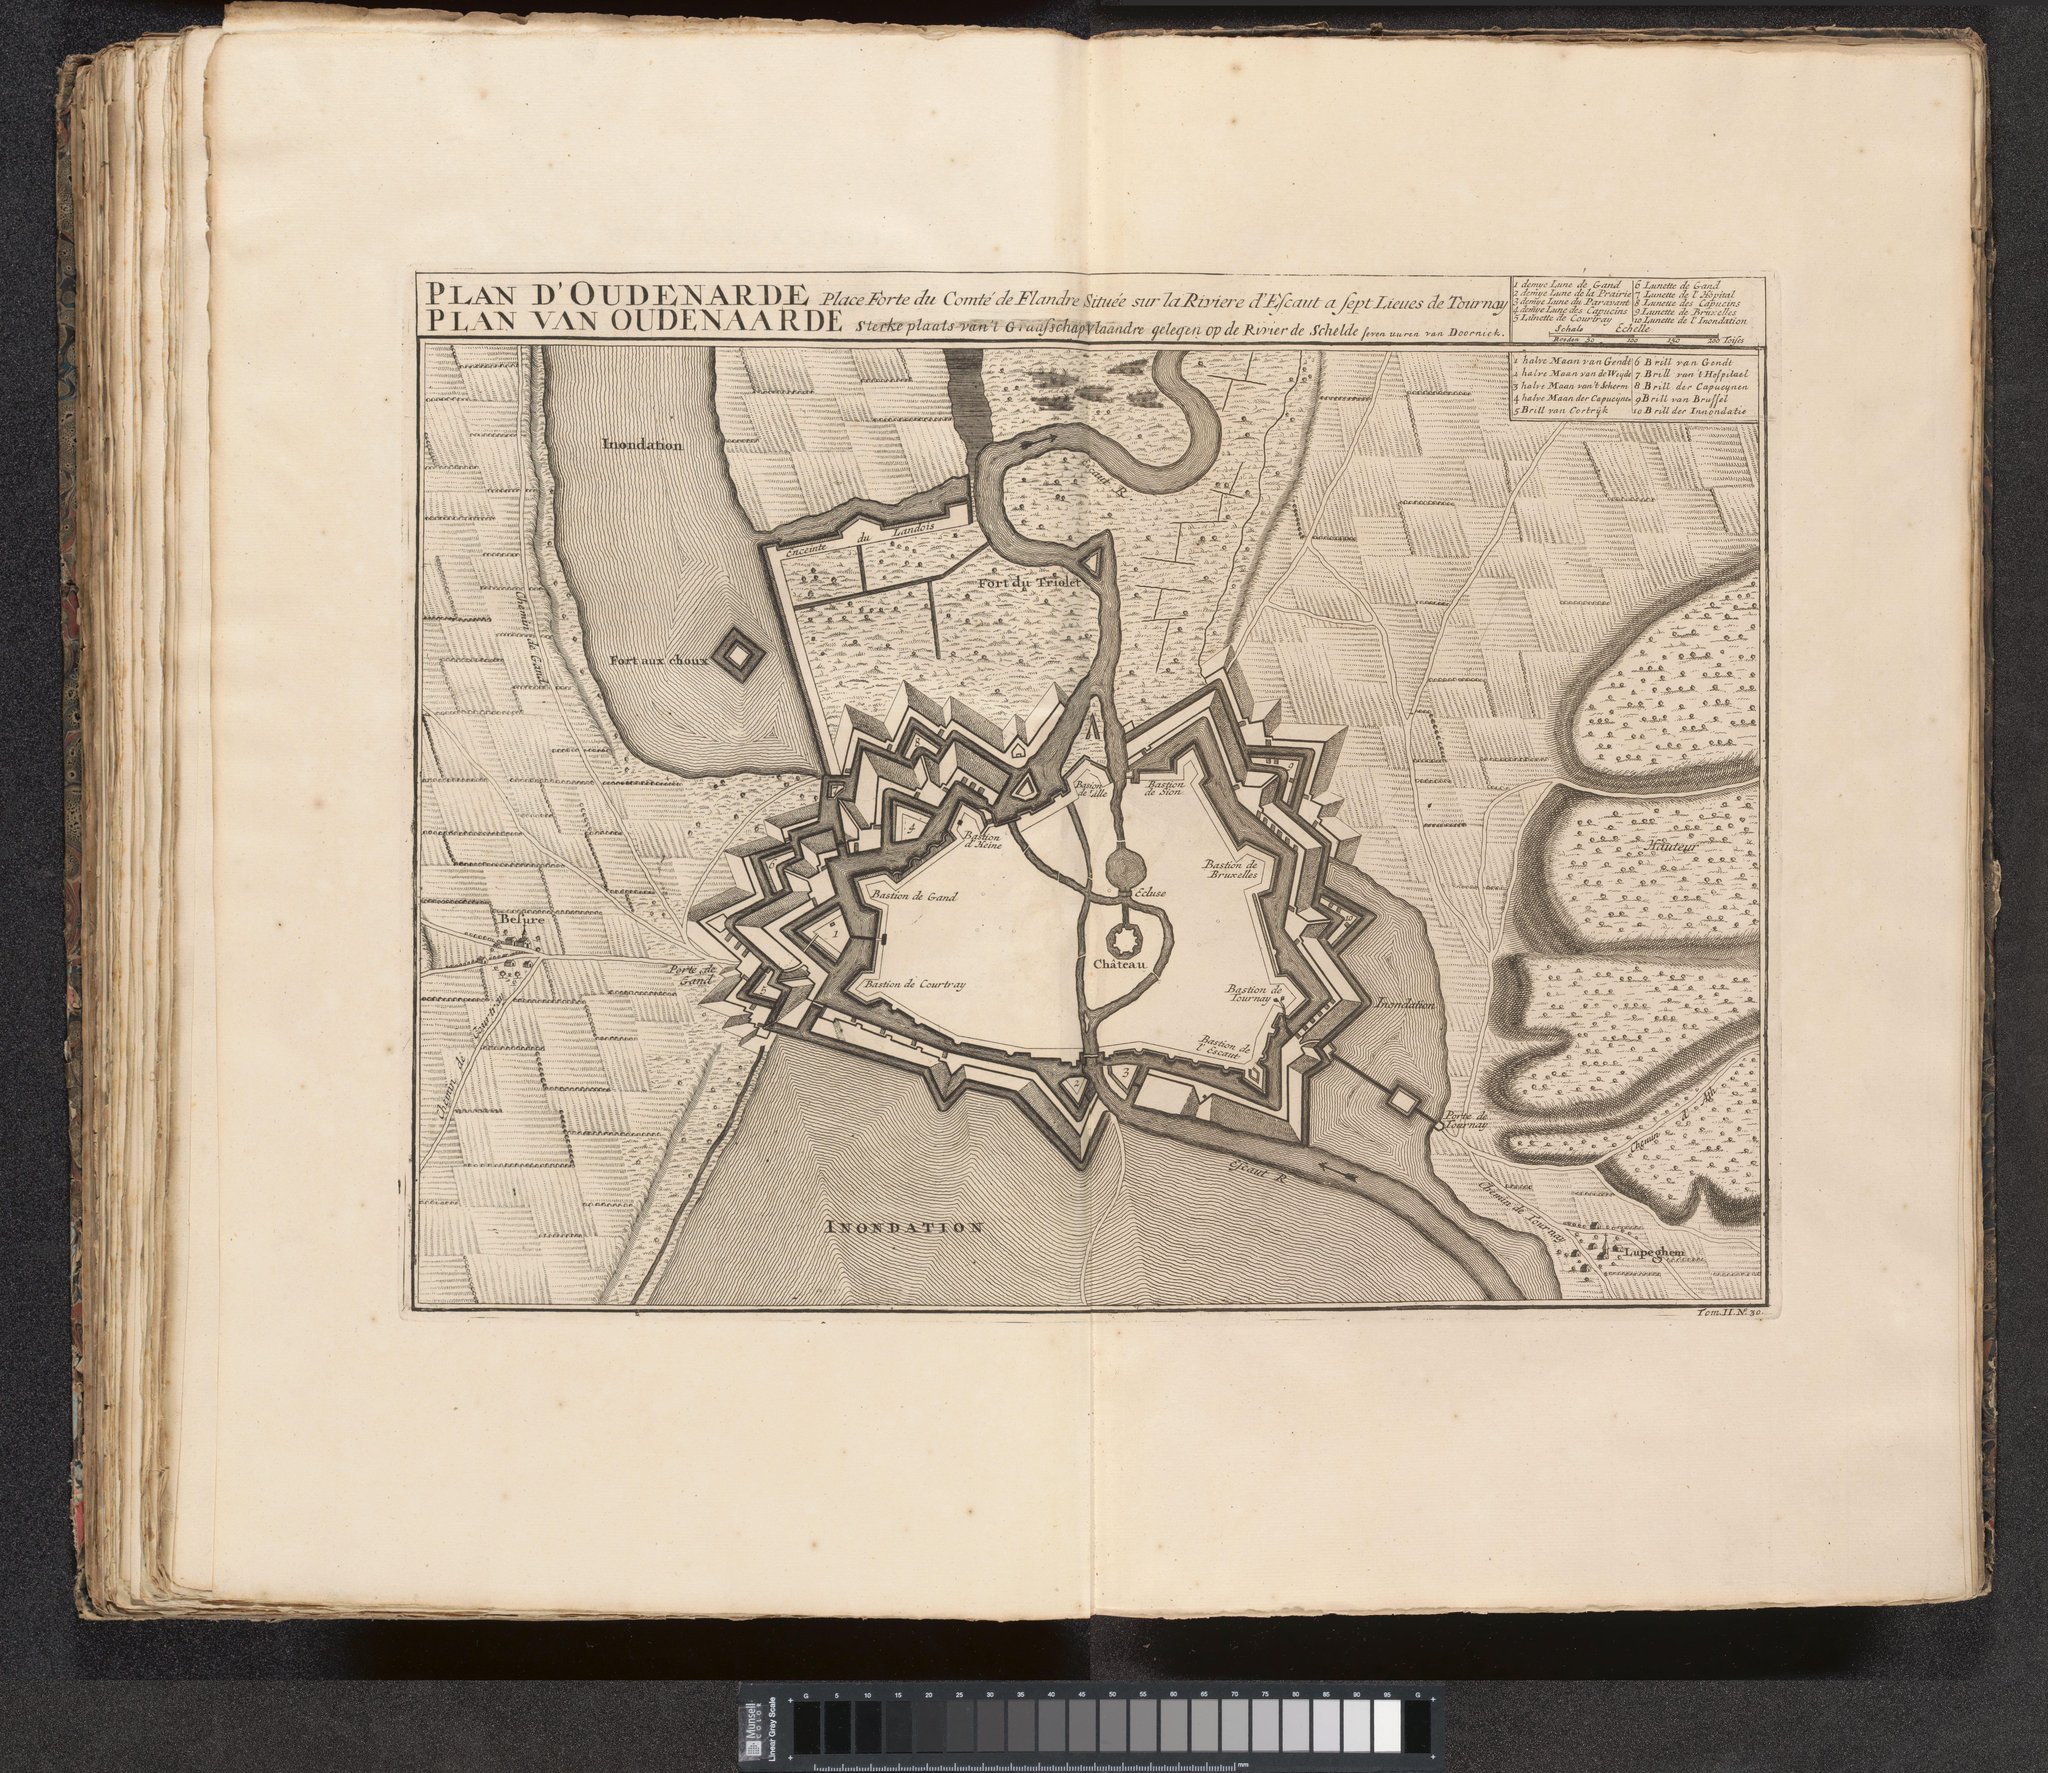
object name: print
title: Plan d'Oudenarde Place Forte du Comté de Flandre (...) / Plan van Oudenaarde Sterke plaats van 't Graafschap Vlaandre (...)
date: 1708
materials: paper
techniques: etching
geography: northern netherlands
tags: johan willem friso (prins van oranje-nassau), john churchill (1e hertog van marlborough), maps of cities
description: Plattegrond van de versterkingen om de Vlaamse stad Oudenaarde, 1708. Genummerd rechtsonder: Tom. II. No. 30. Illustratie in het tweede deel van : [Jean] du Mont, Oorlogskundige beschryving van de veldslagen en belegeringen, der drie ... wydvermaarde krygsoversten... den Prins Eugenius van Savoye, den ... Hertog van Marlborough, en den Prins van Oranje en Nassau-Vriesland, in de editie van 1729. Dit tweede deel is hoofdzakelijk gewijd aan de daden van de hertog van Marlborough en prins Johan Willem Friso.